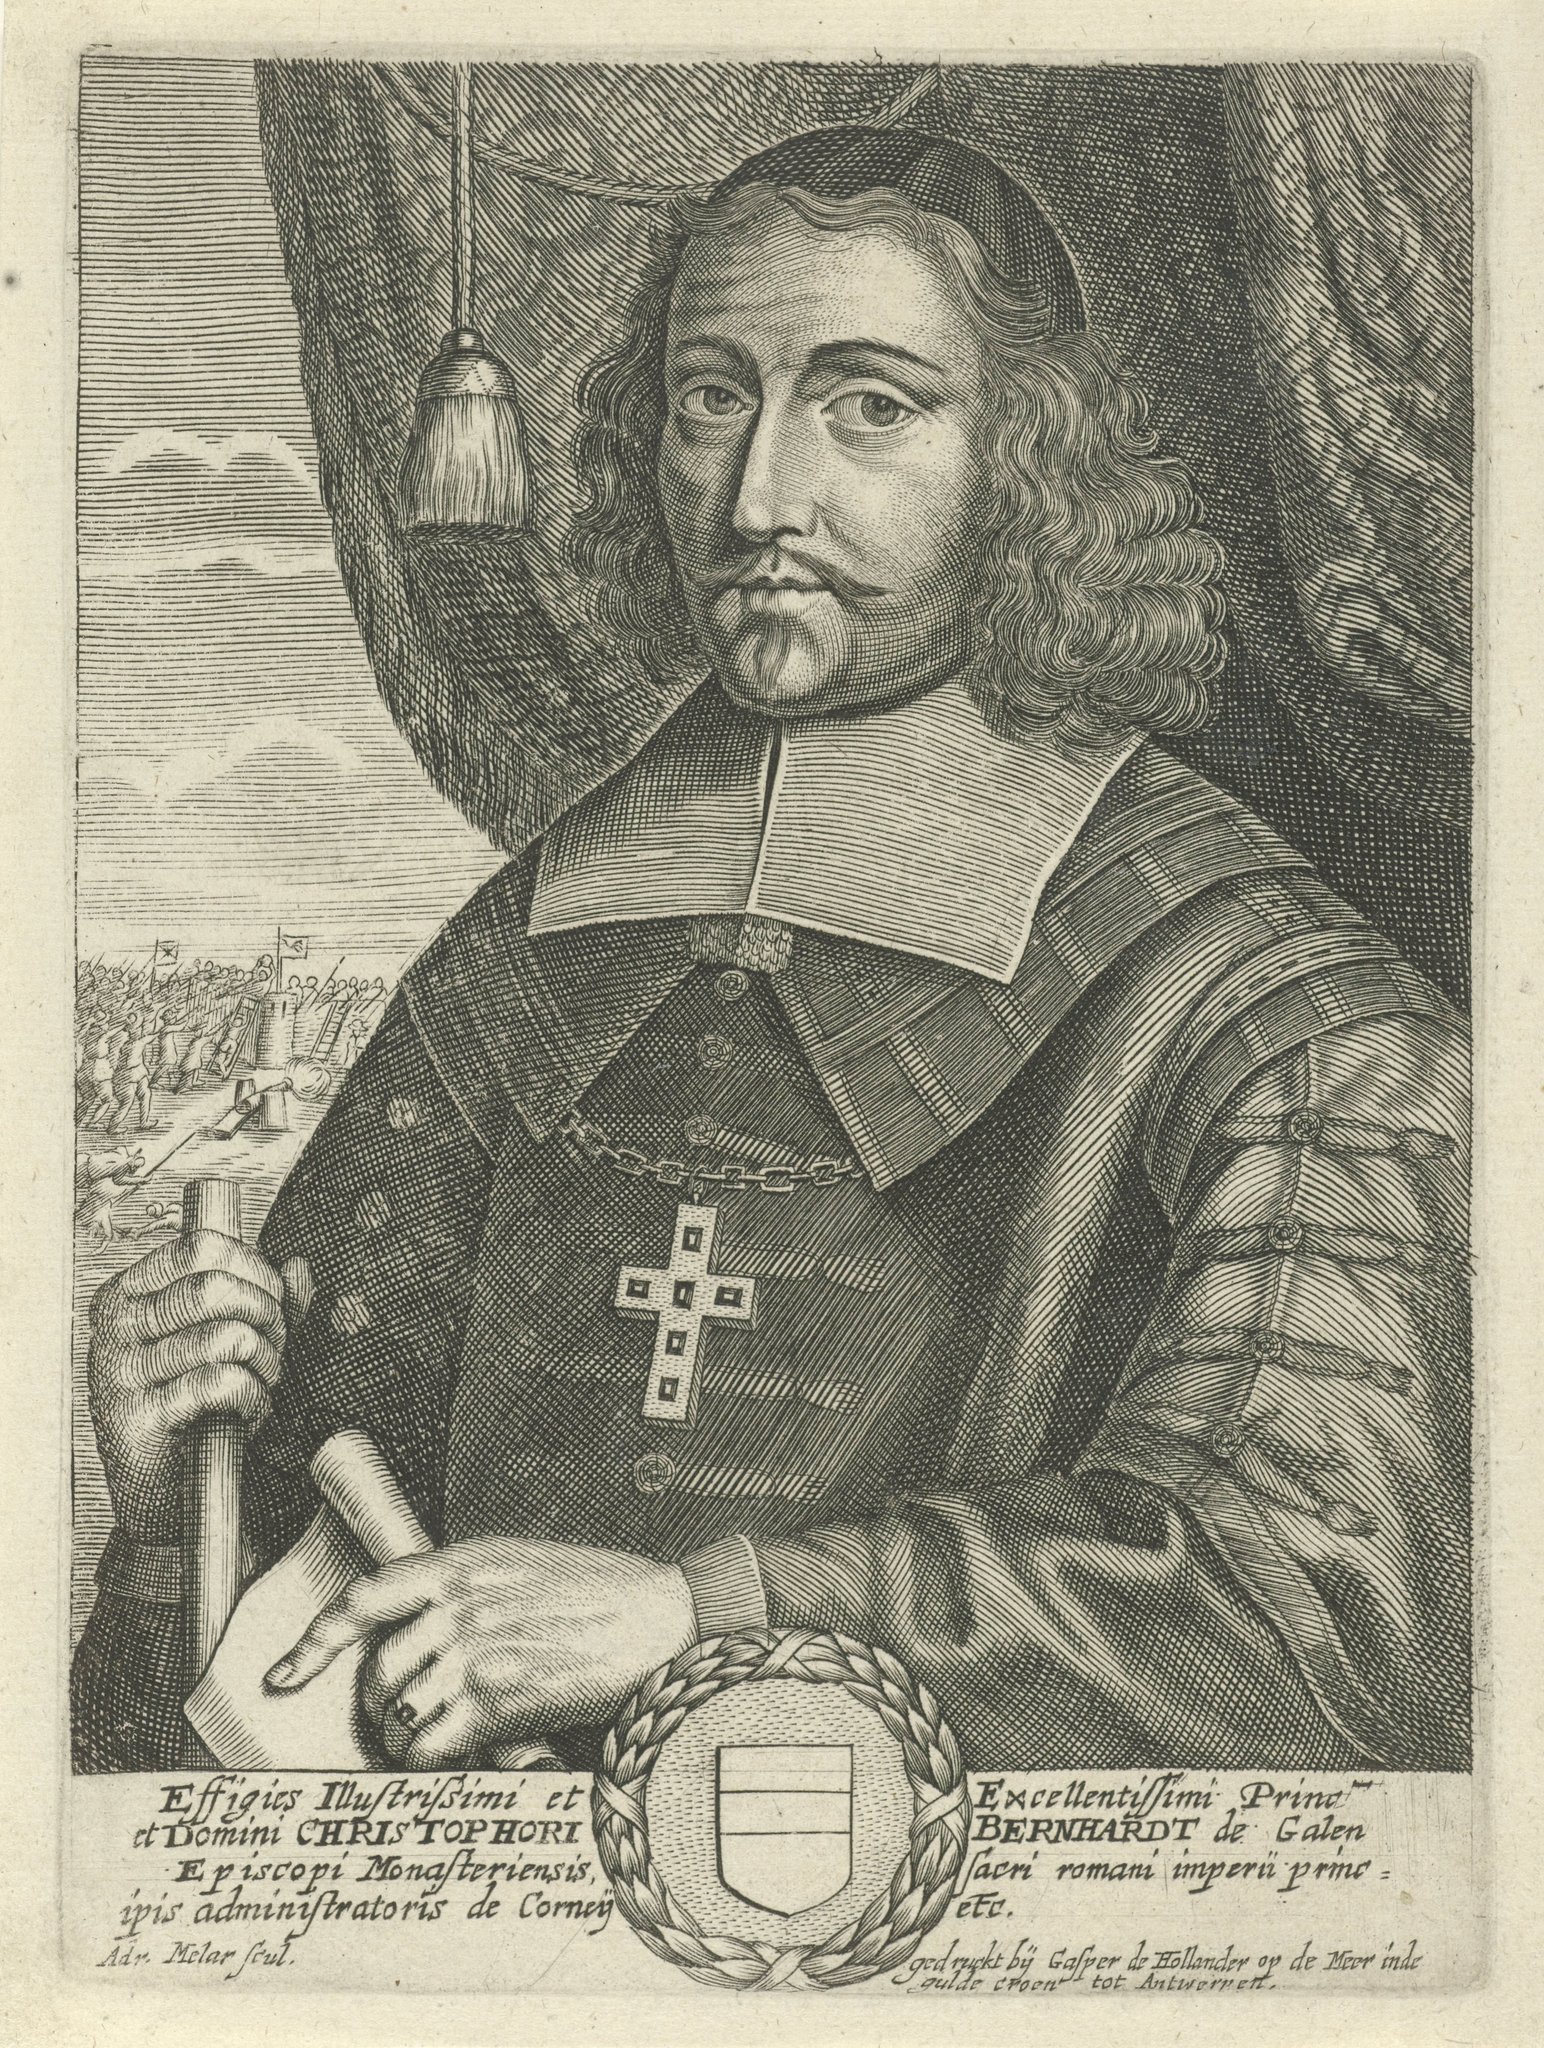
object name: print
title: Portret van Christophori Bernhardt von Galen, bisschop van Munster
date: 1645-1668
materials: paper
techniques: engraving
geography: antwerp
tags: bisschop, christoph bernhard von galen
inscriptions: collector's mark: Lugt 2228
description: Portret van Christophori Bernhardt von Galen, bisschop van Munster, met een kruis op de borst. Op de achtergrond een leger. Midden onder zijn wapenschild en een vierregelige tekst in het Latijn.